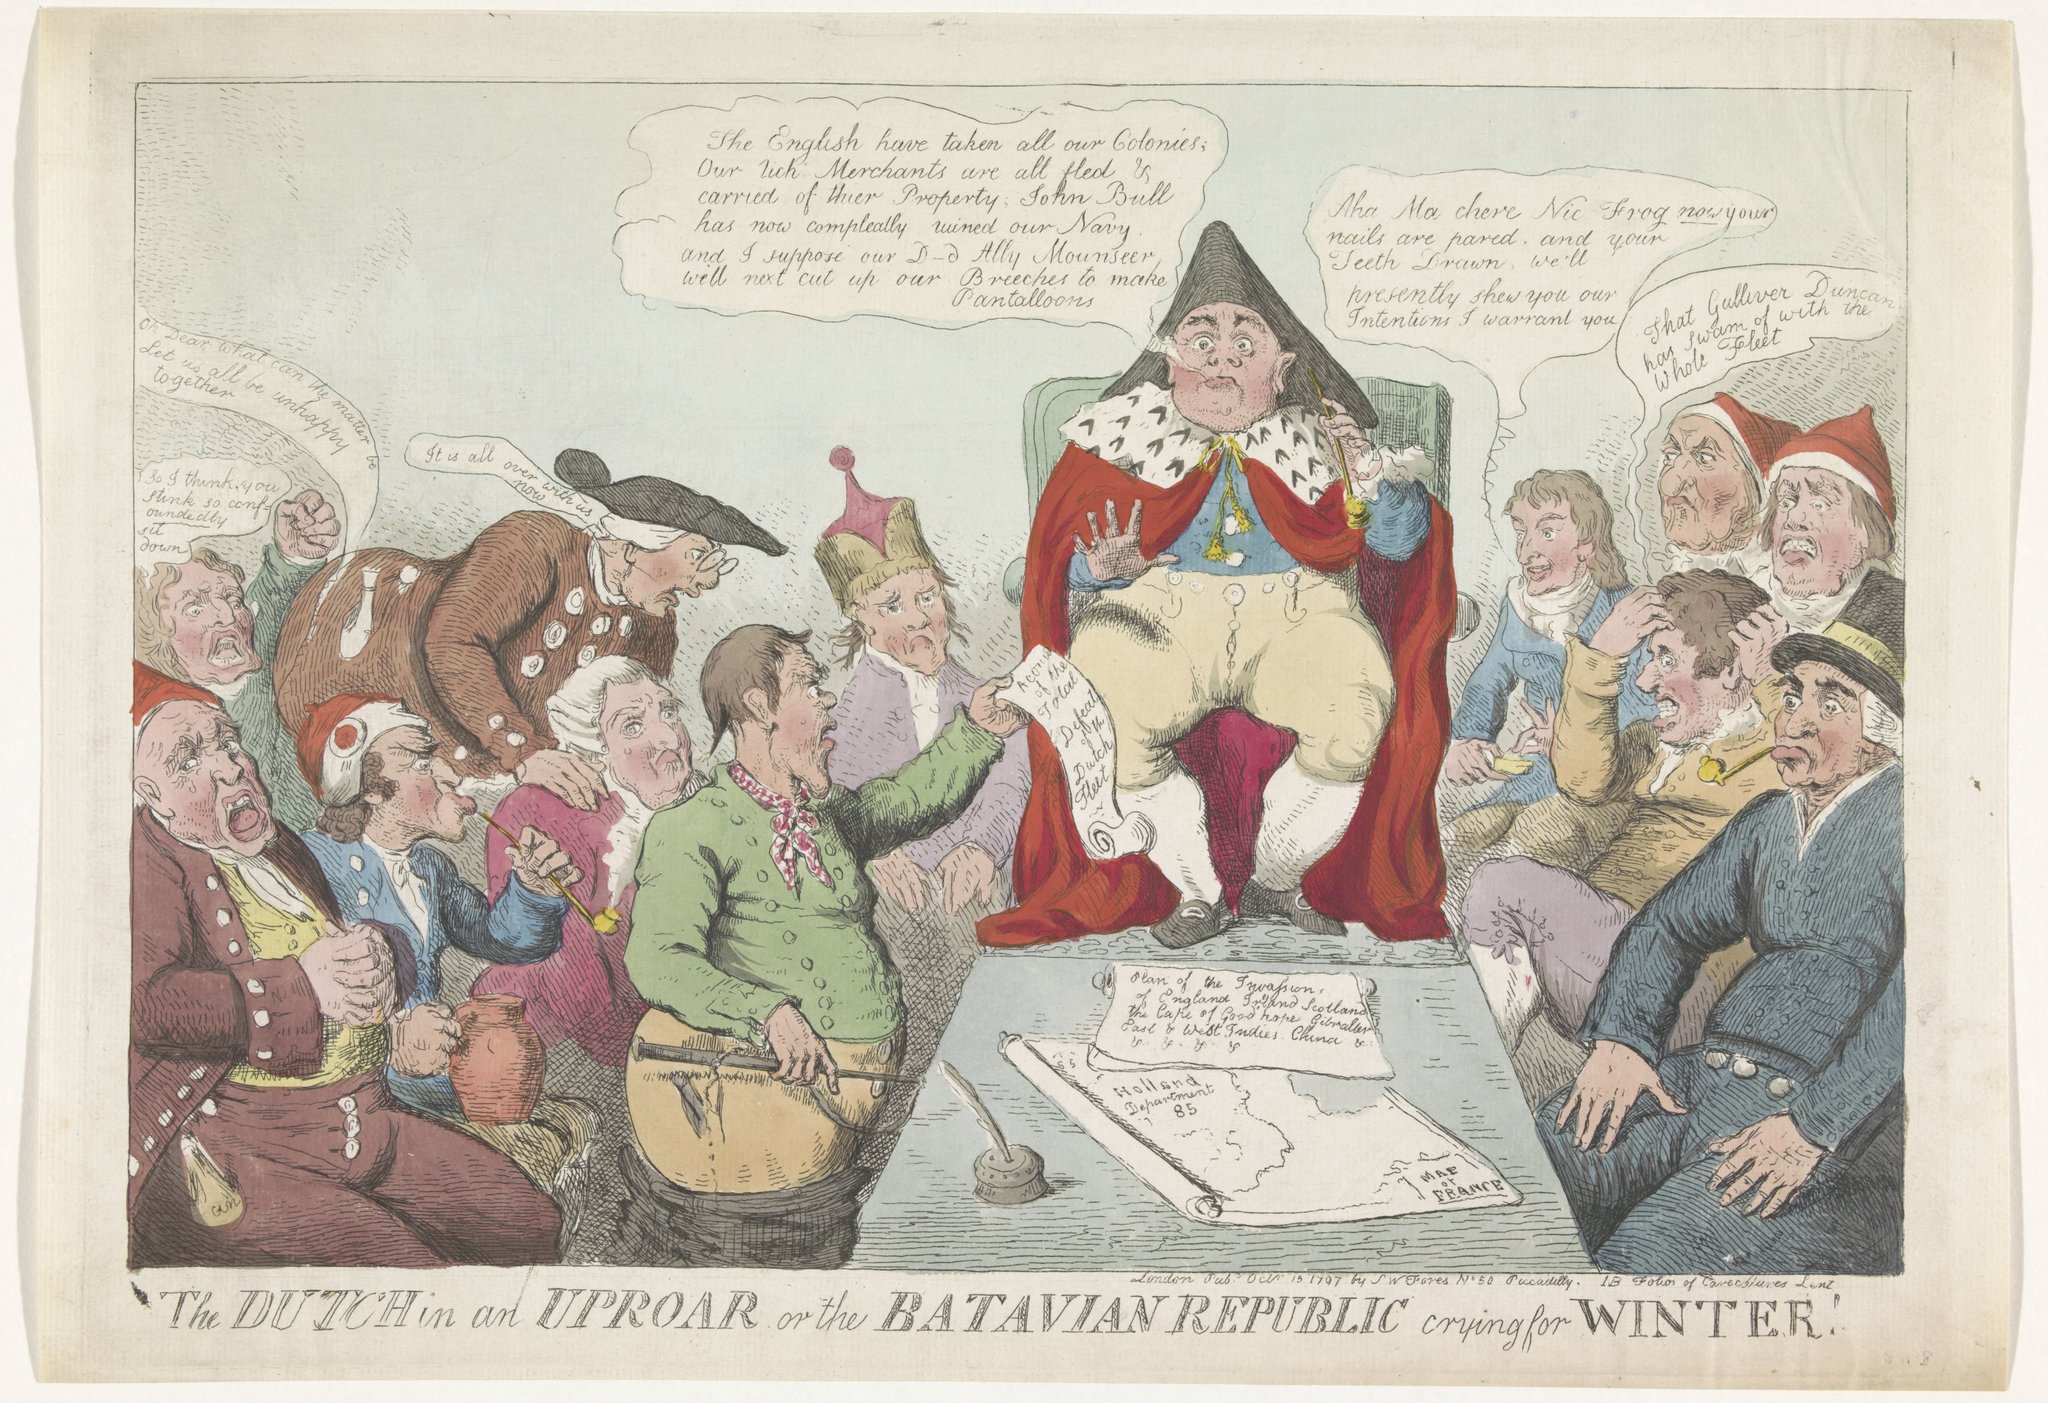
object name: print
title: The Dutch in an Uproar or the Batavian Republic crying for Winter!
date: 1797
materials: paper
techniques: etching, hand coloring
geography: london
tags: paris, jan willem de winter, pipe ~ tobacco, snuff, political caricatures and satires, battle of camperdown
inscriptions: collector's mark: Lugt 2228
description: Engelse spotprent op de Nederlanders na de nederlaag van de Bataafse vloot onder viceadmiraal De Winter tegen de Britse vloot in de slag bij Kamperduin op 11 oktober 1797. Op een troon zit een pijprokende Hollander gekleed in een koningsmantel, om de tafel heen is een groep mannen verzameld. Allen zijn verbolgen over het slechte nieuws van de nederlaag in de zeeslag gebracht door een boodschapper. Op de achtergrond neemt een Fransman wat snuif uit een doosje. Op tafel liggen twee documenten: een kaart van Frankrijk met Holland als 'Departement 85' en een plan voor de invasie van Engeland en herovering van verloren koloniën.